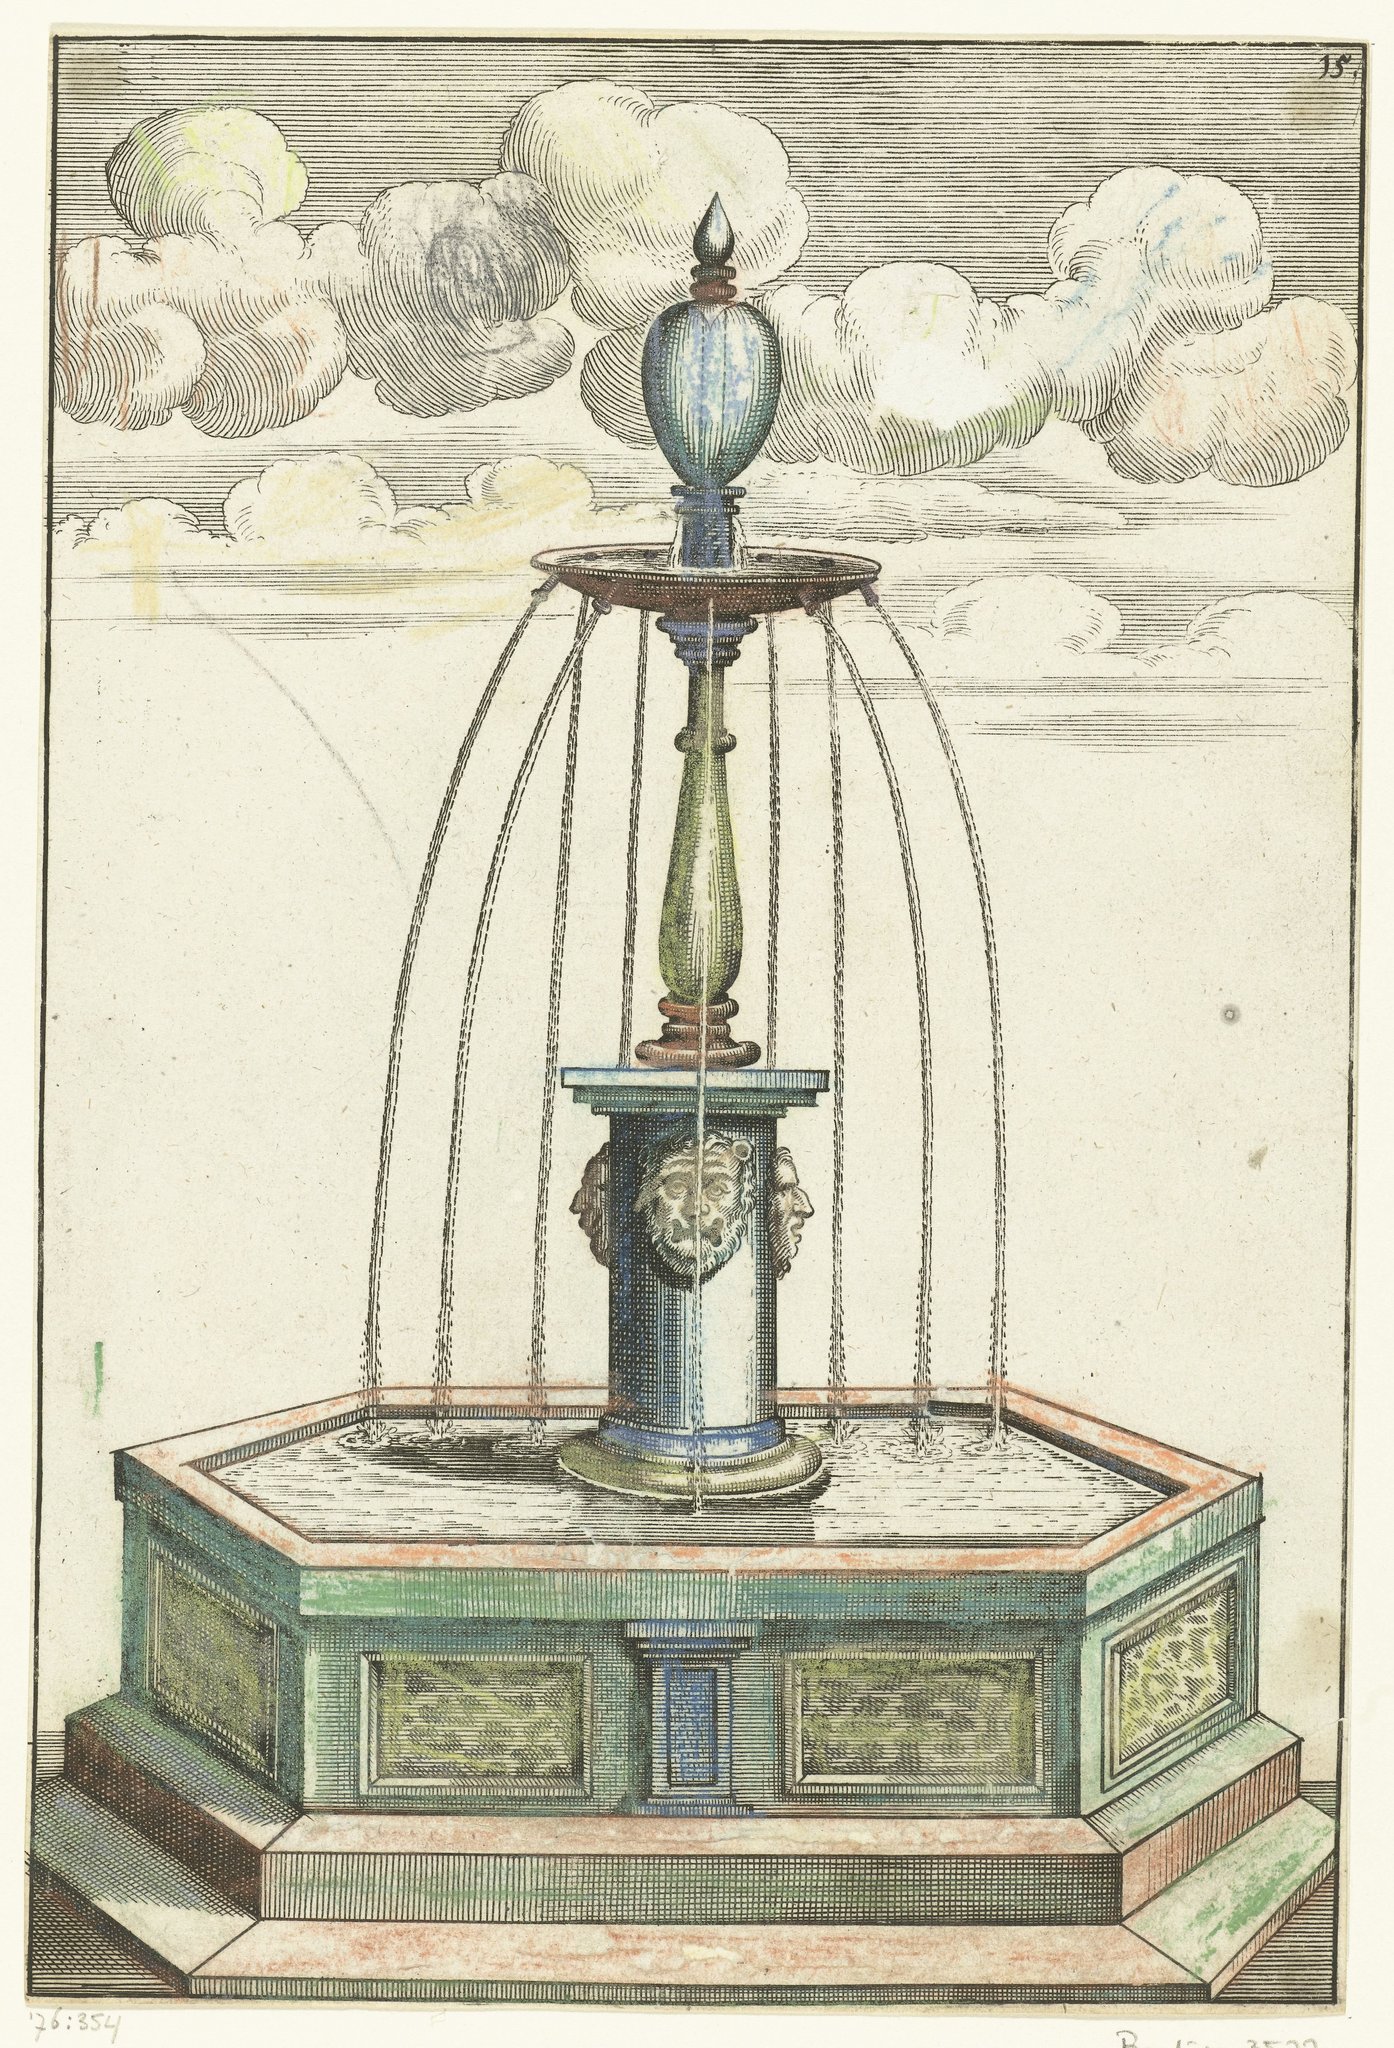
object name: print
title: Zeshoekig bassin met korte zuil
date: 1664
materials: paper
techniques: etching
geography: germany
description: De zuil is gedecoreerd met leeuwenkoppen, bovenop staat een rond bassin met daarin een ovale vorm waarin een hartvorm te zien is. Het water stroomt uit gaatjes in het bassin.